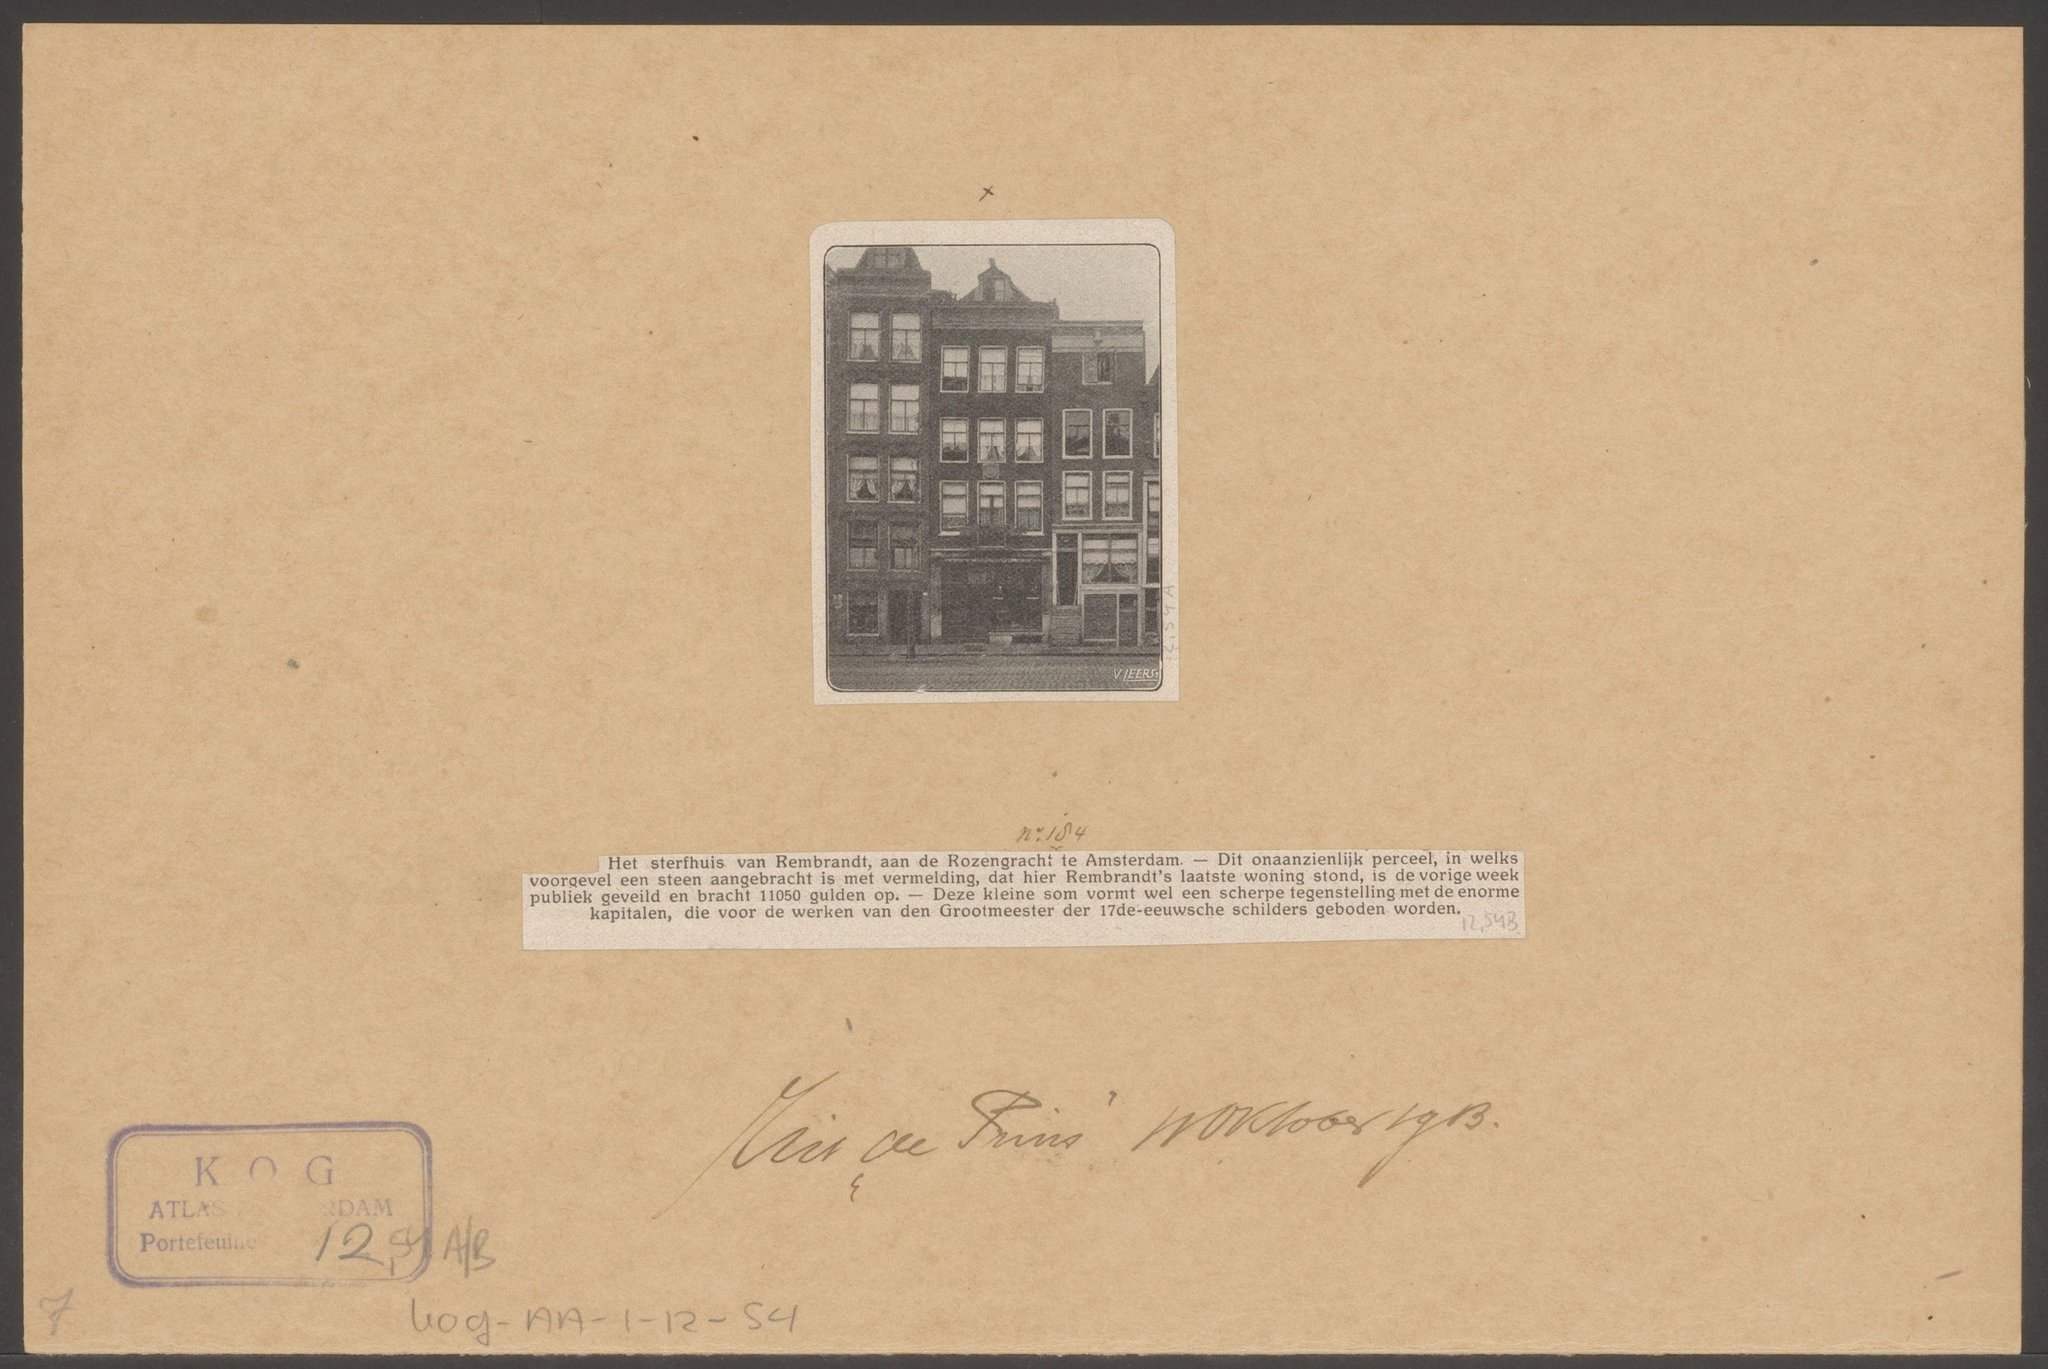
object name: photomechanical print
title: Gezicht op Rozengracht 184-190, het sterfhuis van Rembrandt van Rijn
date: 1913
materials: paper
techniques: letterpress printing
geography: amsterdam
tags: city-view in general; 'veduta', the usual house or row of houses, façade (of house or building)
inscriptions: collector's mark: ‘12-54A/B’ Lugt 1641b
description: Onderwerpsrubriek binnen de Atlas Amsterdam: Rokin, Rotterdammersloot, Rozengang, Rozengracht, Rozenstraat, Rusland, Rustenburgerstraat, Ruysdaelkade, Ruysdaelstraat, Ruyterkade (de), Ruyterweg (Admiraal de). Genummerd rechtsboven: 5.